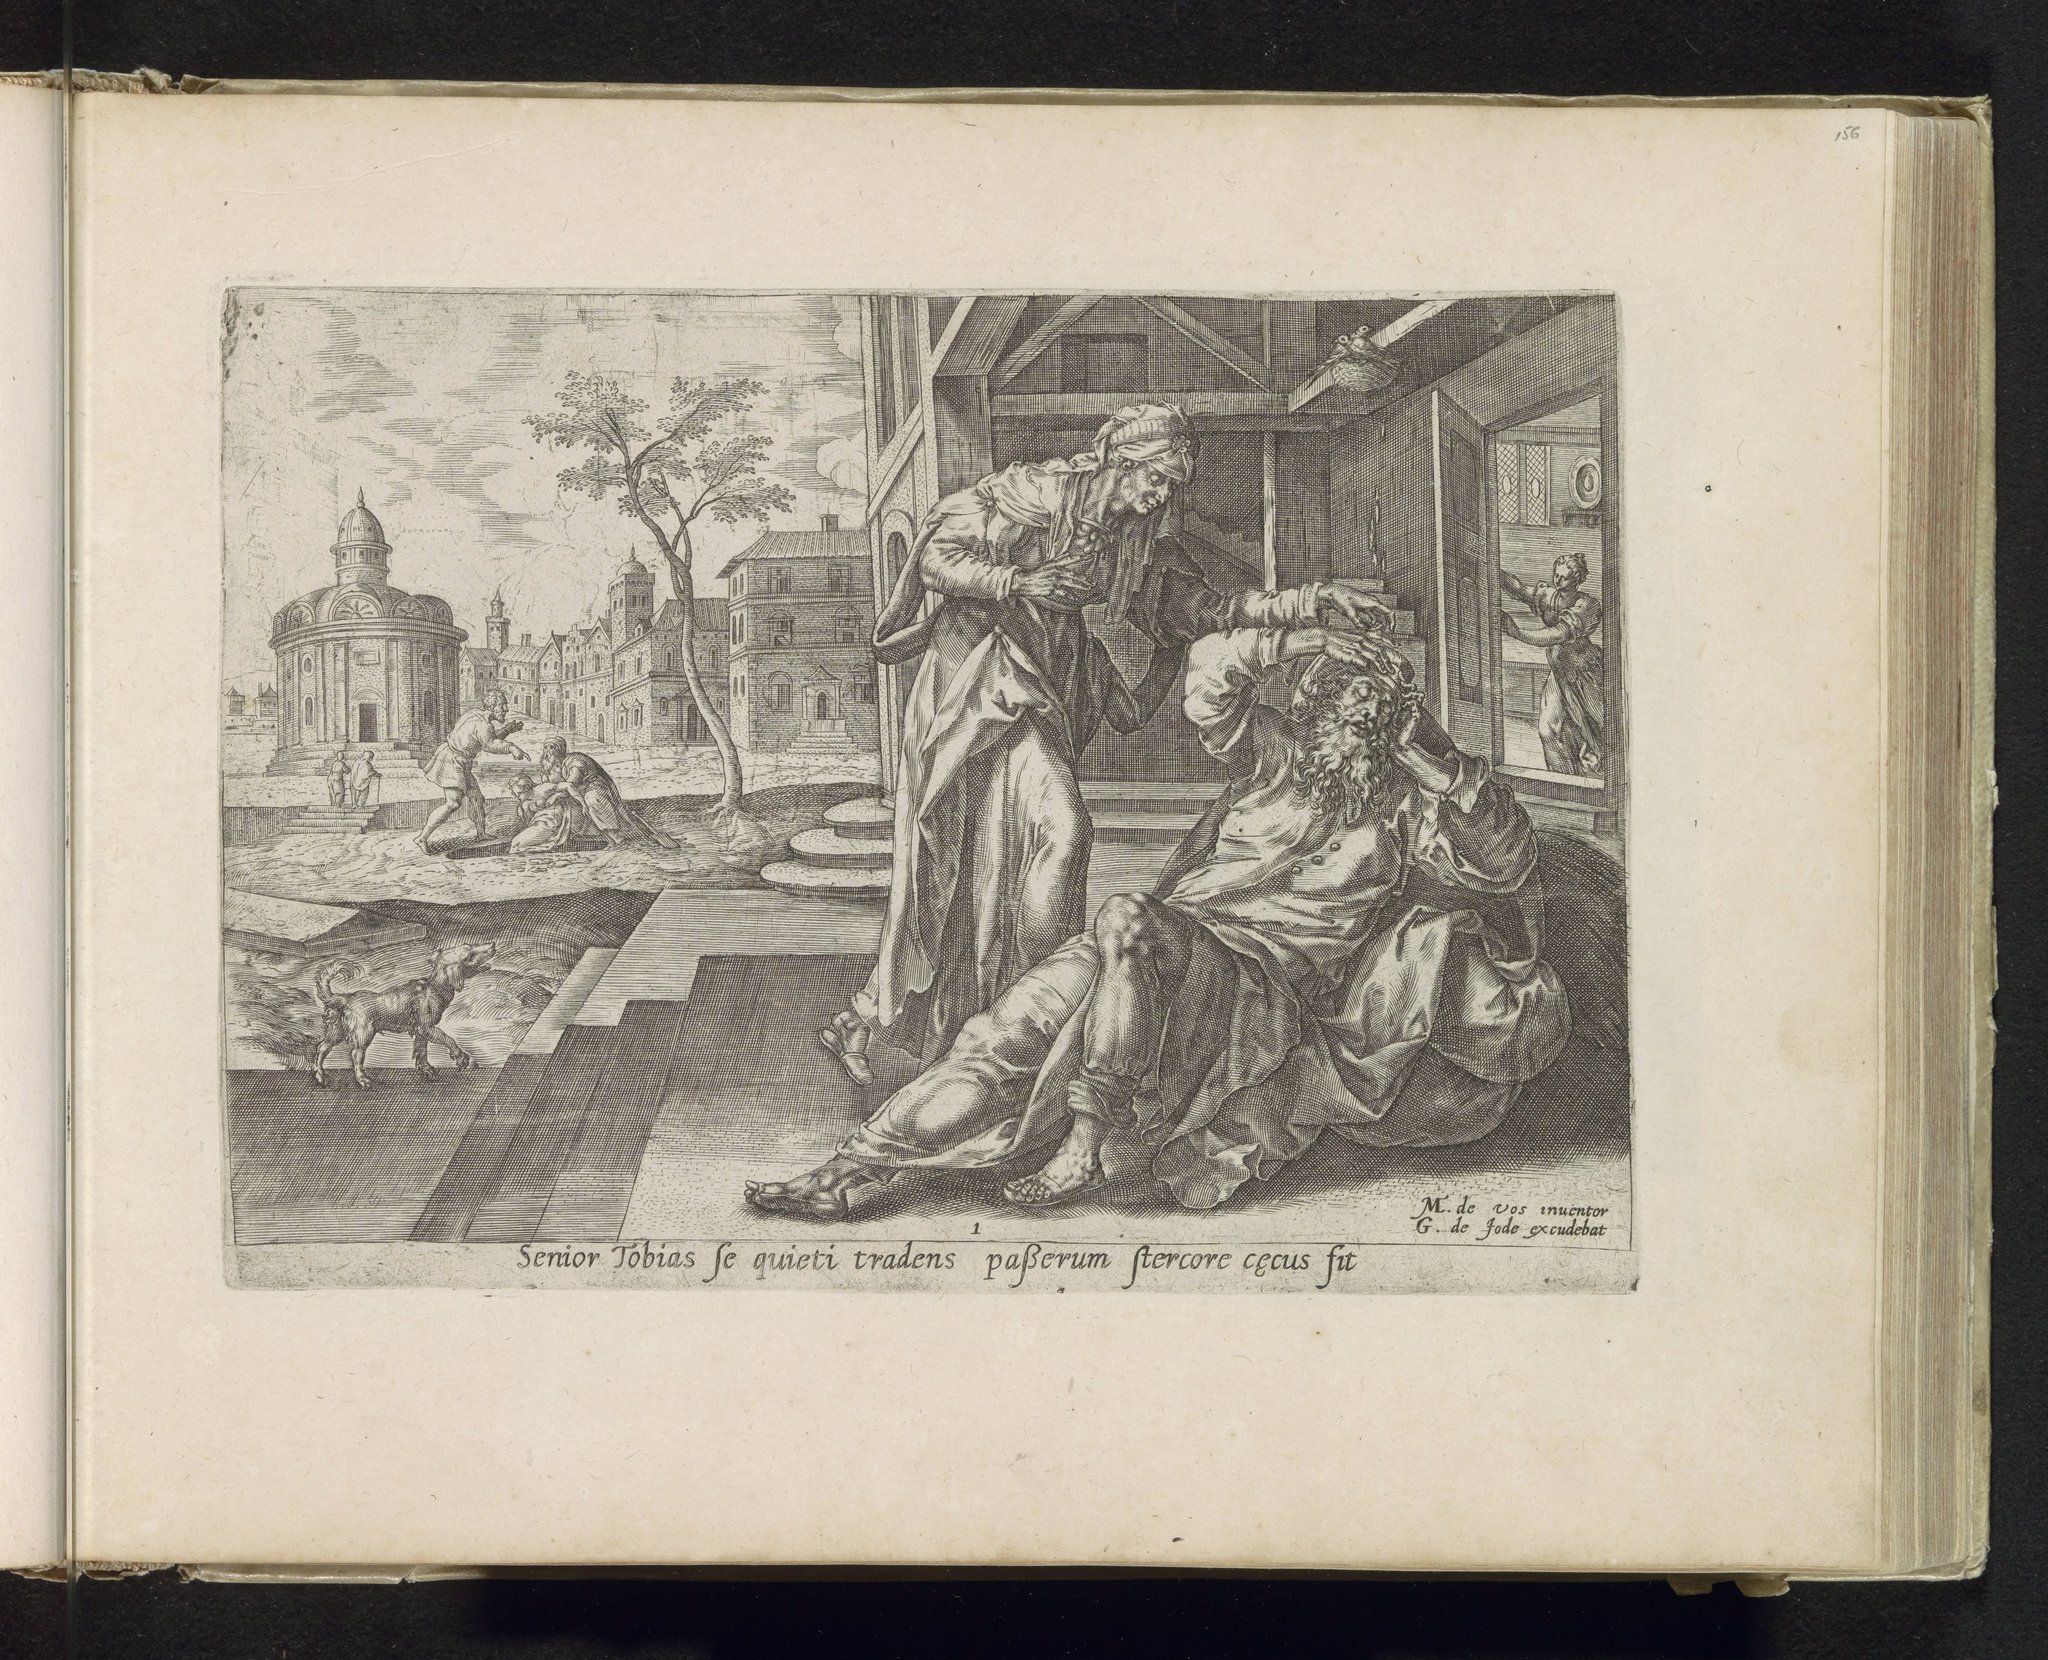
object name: print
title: Thesaurus sacrarum historiaru[m] veteris testame[n]ti, elega[n]tissimis imaginibus expressu[m] excelle[n]tissimoru[m] in hac arte viroru[m] opera: nu[n]c primu[m] in luce[m] editus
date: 1585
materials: paper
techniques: engraving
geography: antwerp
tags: tobit buries a dead man at night, a bird dropping falls in tobit's eyes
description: Links op de achtergrond begraaft Tobit het lichaam van de vermoorde man, die door Tobias op straat is gevonden. Na de begrafenis valt Tobit in slaap tegen de muur van zijn huis. Een van de vogels in het nestje boven zijn hoofd laat zijn vogelpoep vallen op Tobits ogen, waardoor hij blind wordt. Onderaan in de marge een verklarende tekst in het Latijn. Naar Tobit 2:1-10. Deze prent maakt deel uit van een album.